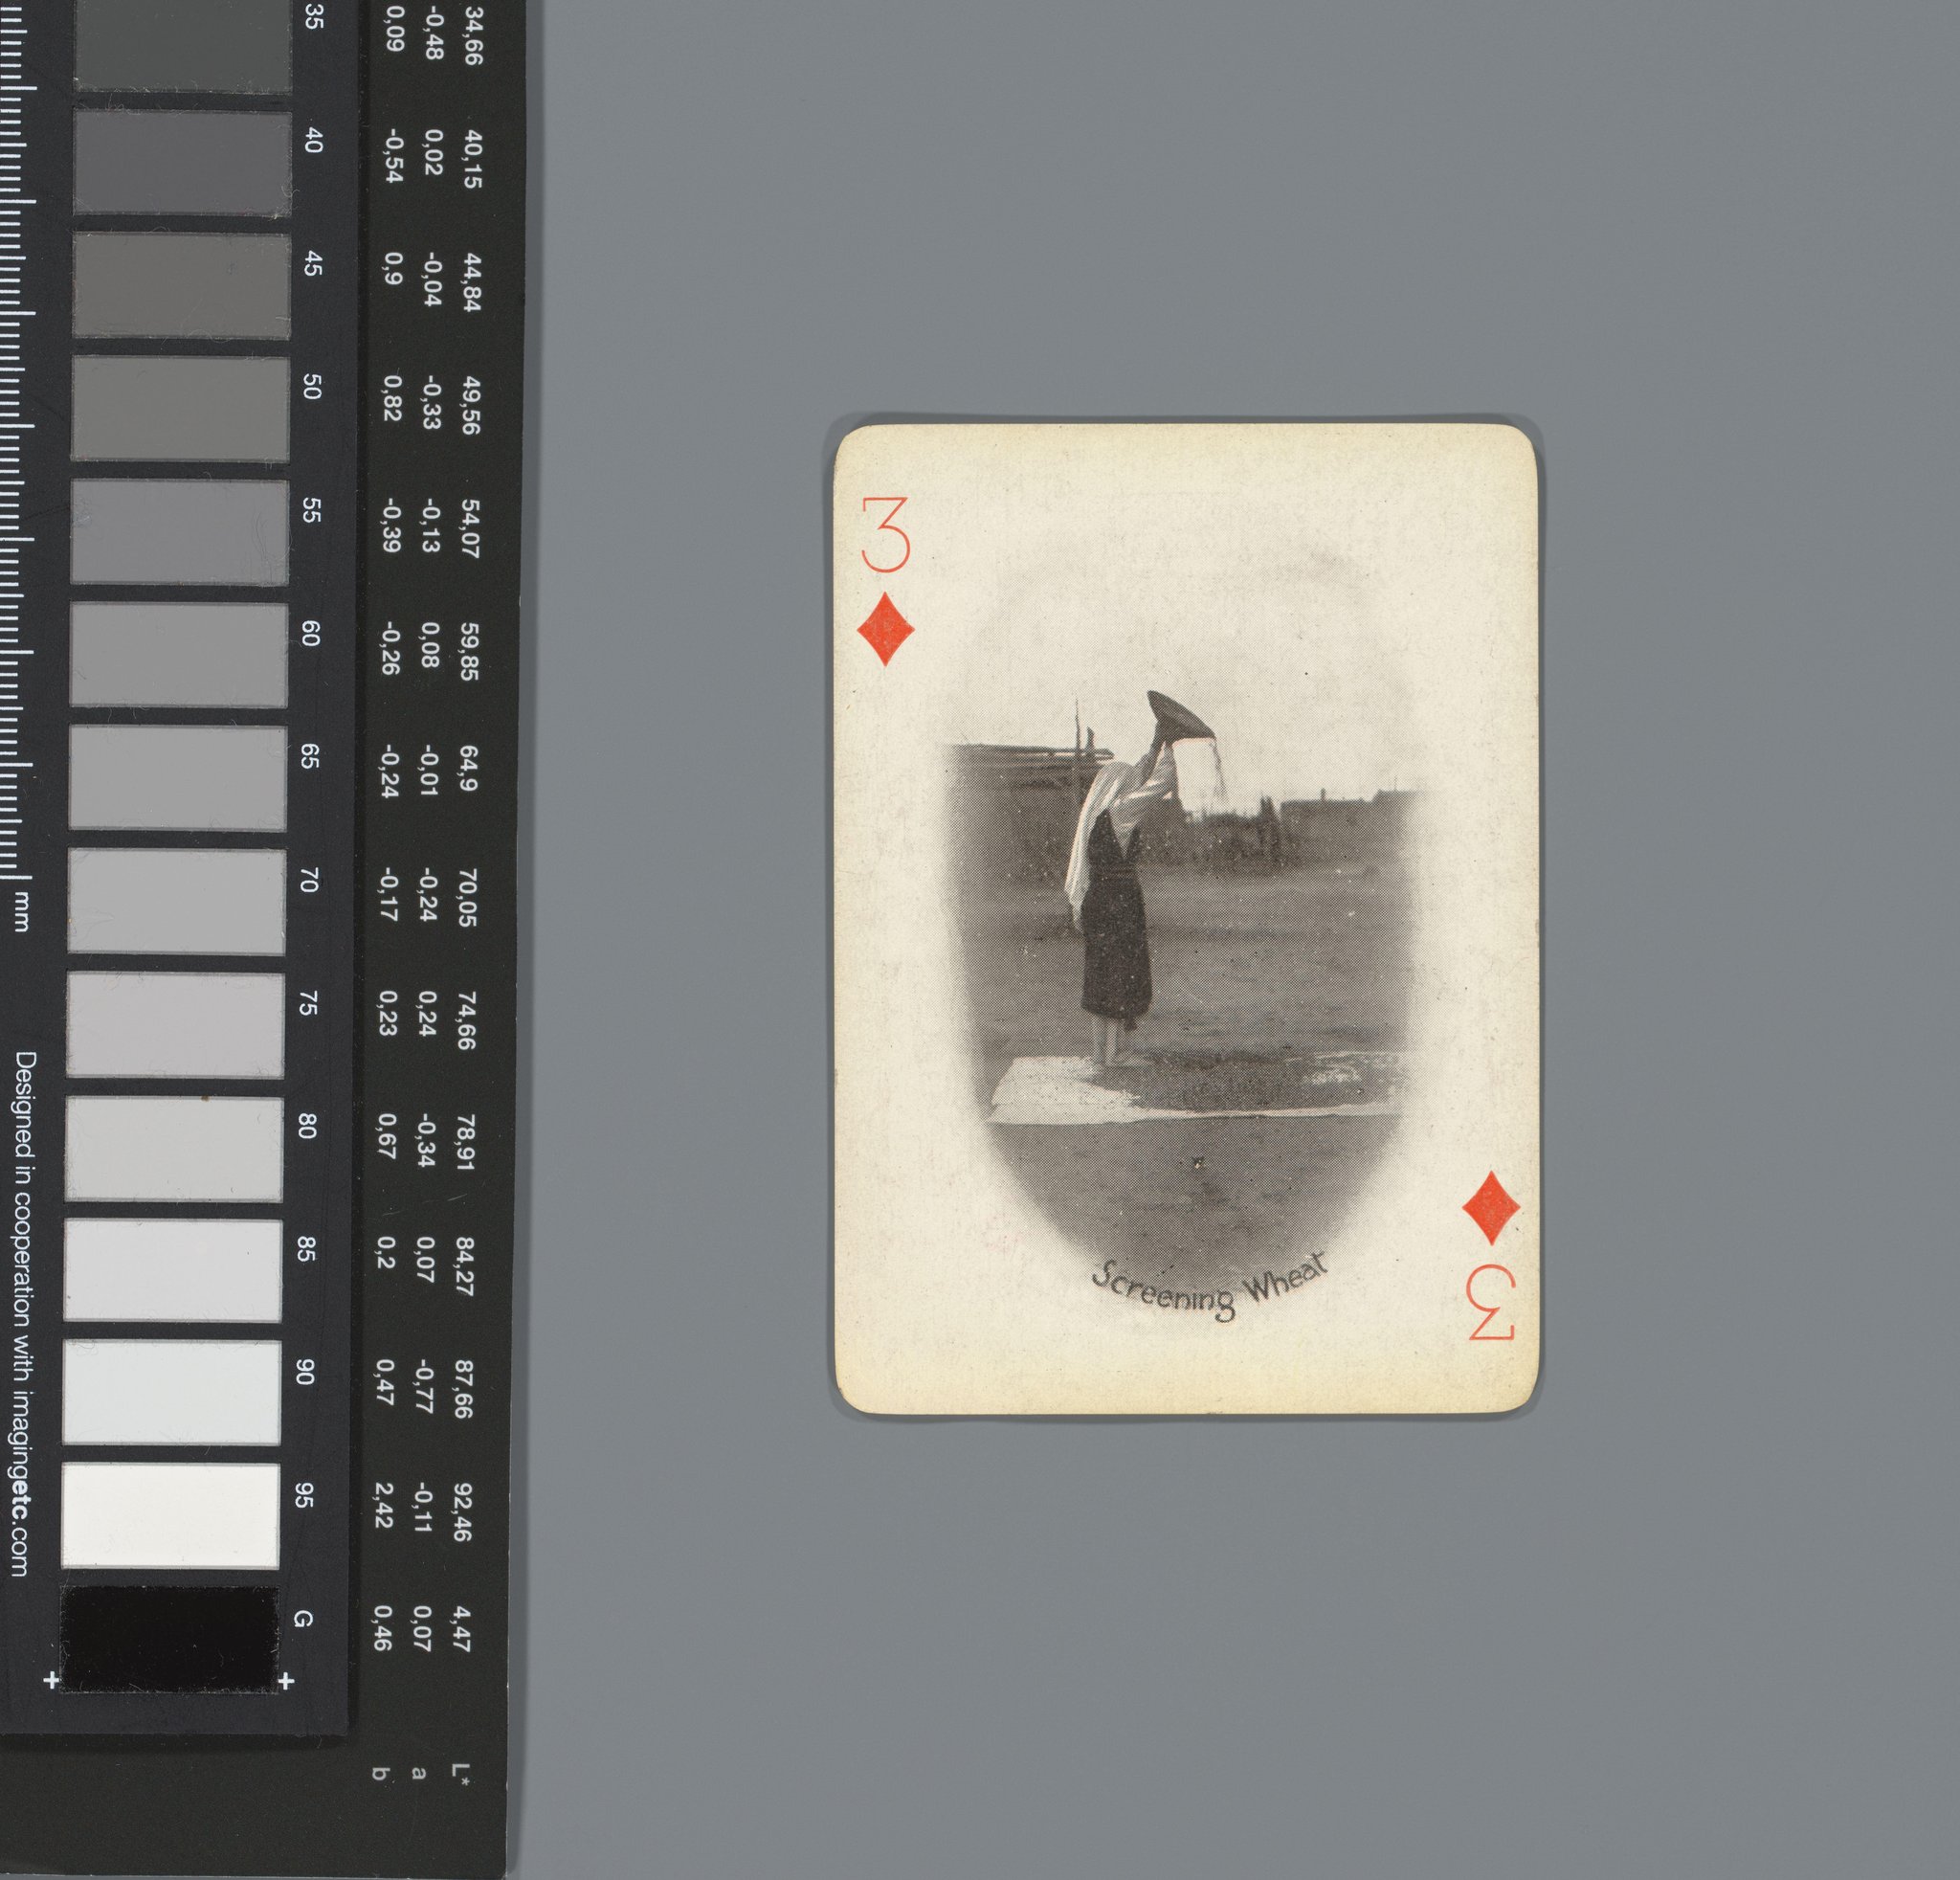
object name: photograph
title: Screening Wheat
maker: adam clark vroman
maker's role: fotograaf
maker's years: 1856-1916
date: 1900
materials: paper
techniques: autotype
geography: los angeles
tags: united states of america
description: Speelkaart uit doosje met 53 speelkaarten met afbeeldingen in autotypie van Native Americans. De inhoud bevat een complete set speelkaarten inclusief joker.